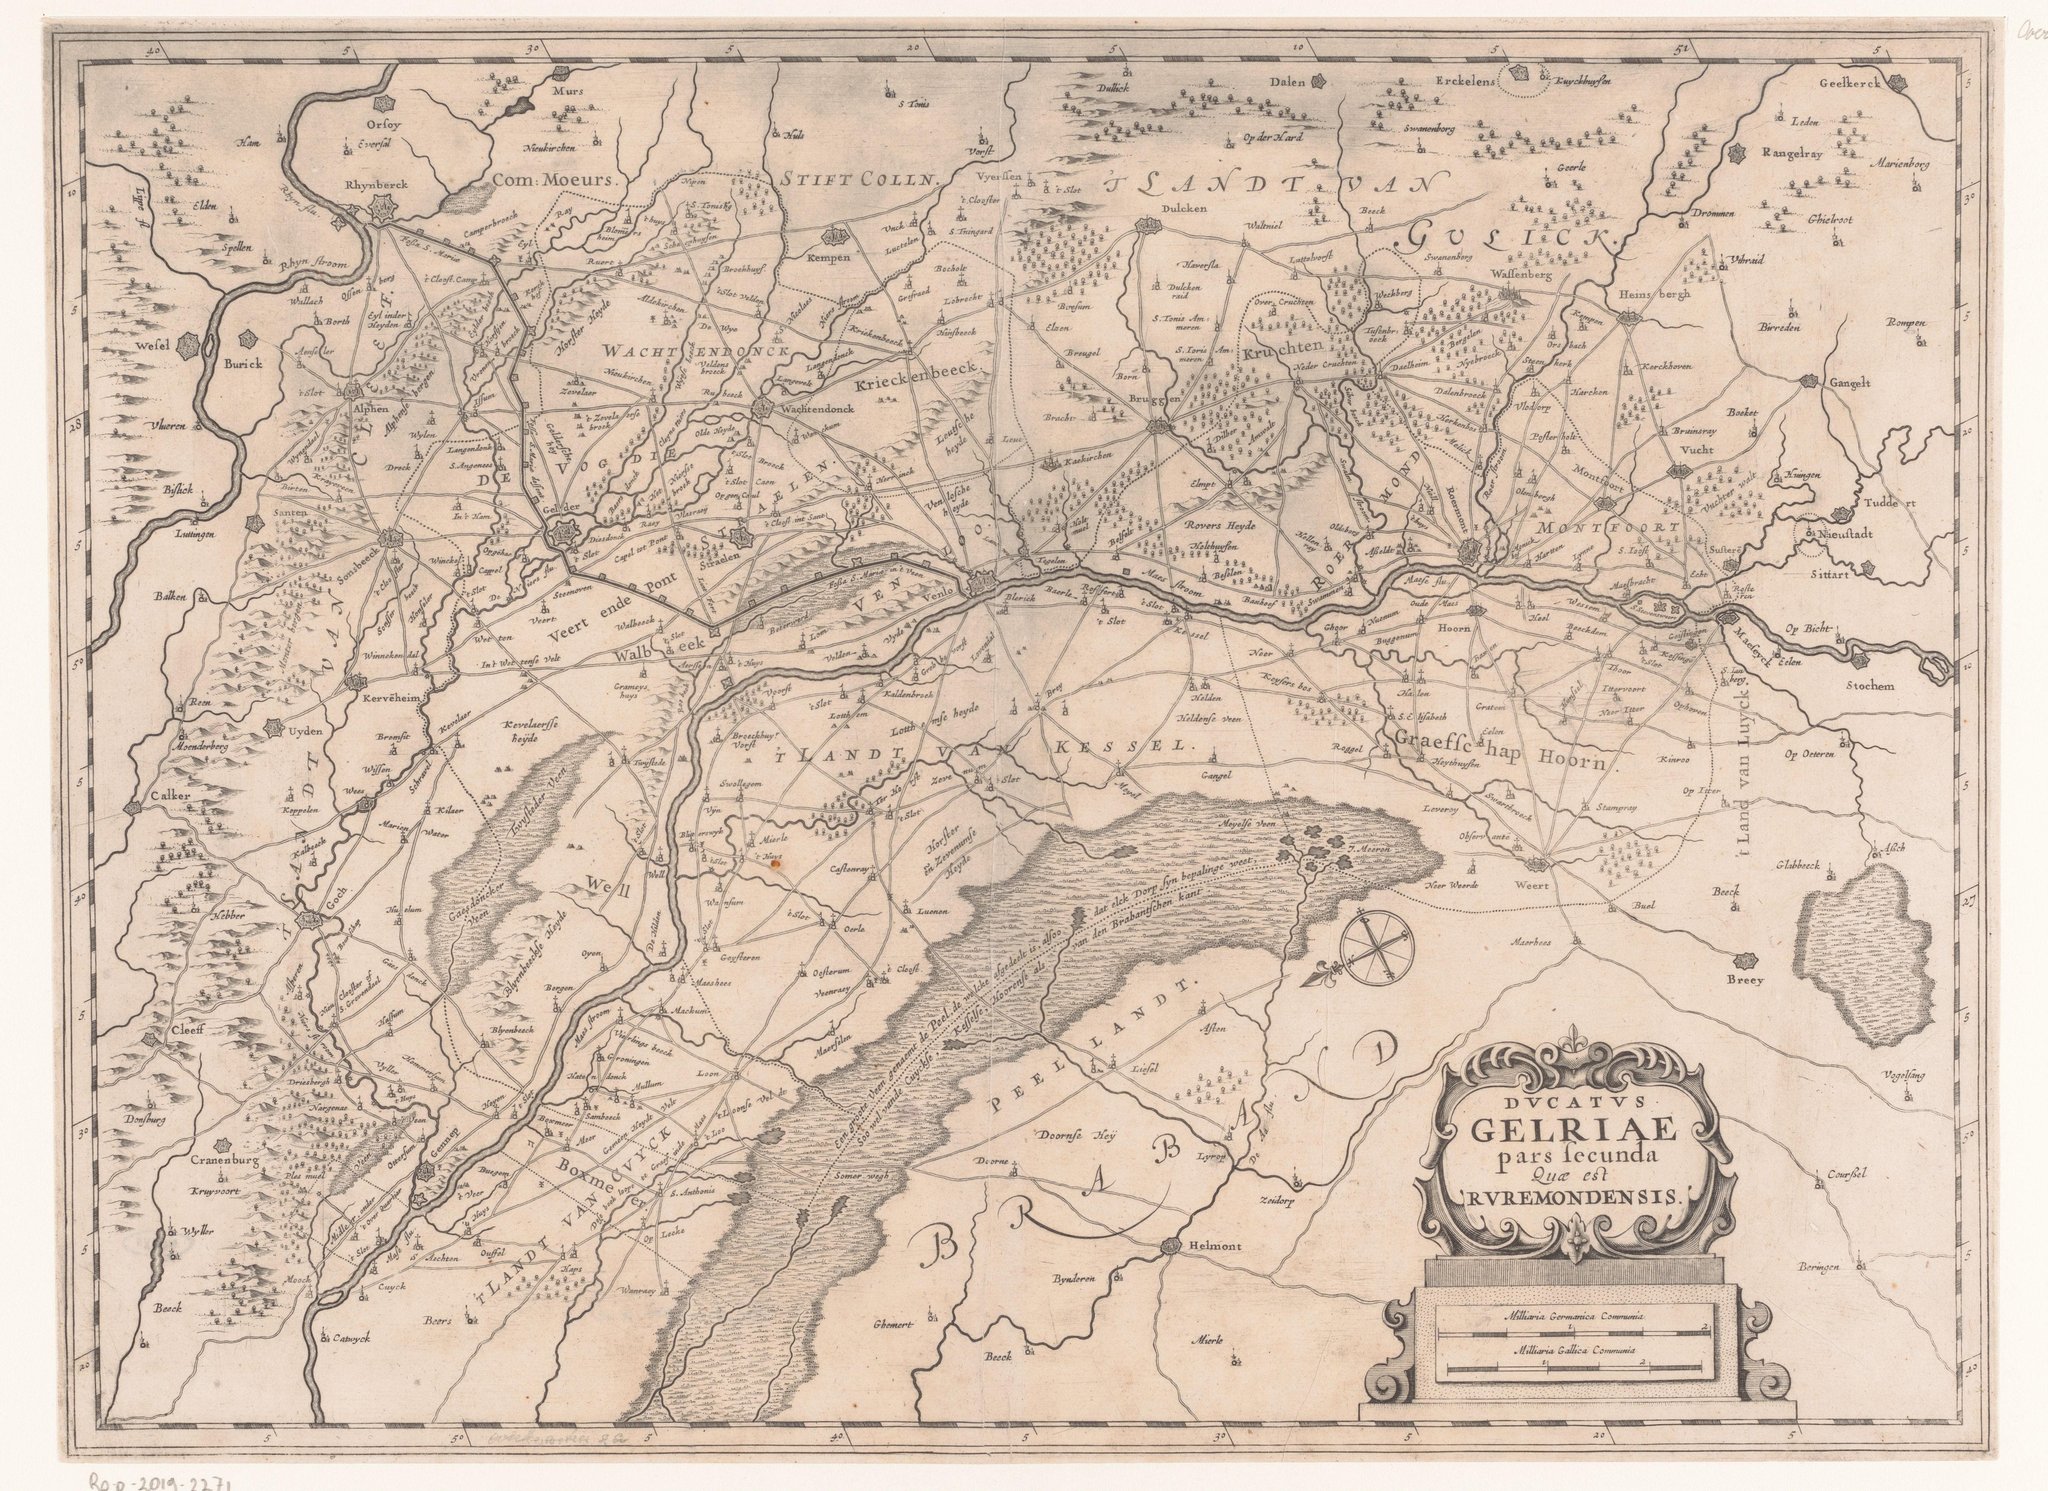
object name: print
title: Ducatus Gelriae pars secunda quae est 'Ruremondensis'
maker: Anonymous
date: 1644-1680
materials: paper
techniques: engraving, etching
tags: maps of separate countries or regions, gelderland, guelders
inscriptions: collector's mark: Lugt 2228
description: Rechtsonder de titelcartouche, met daaronder twee schaalstokken: 2 Milliaria Germanica Communia / 2 1/2 Milliara Gallica Communia. De kaart is voorzien van een gradenverdeling langs de randen.